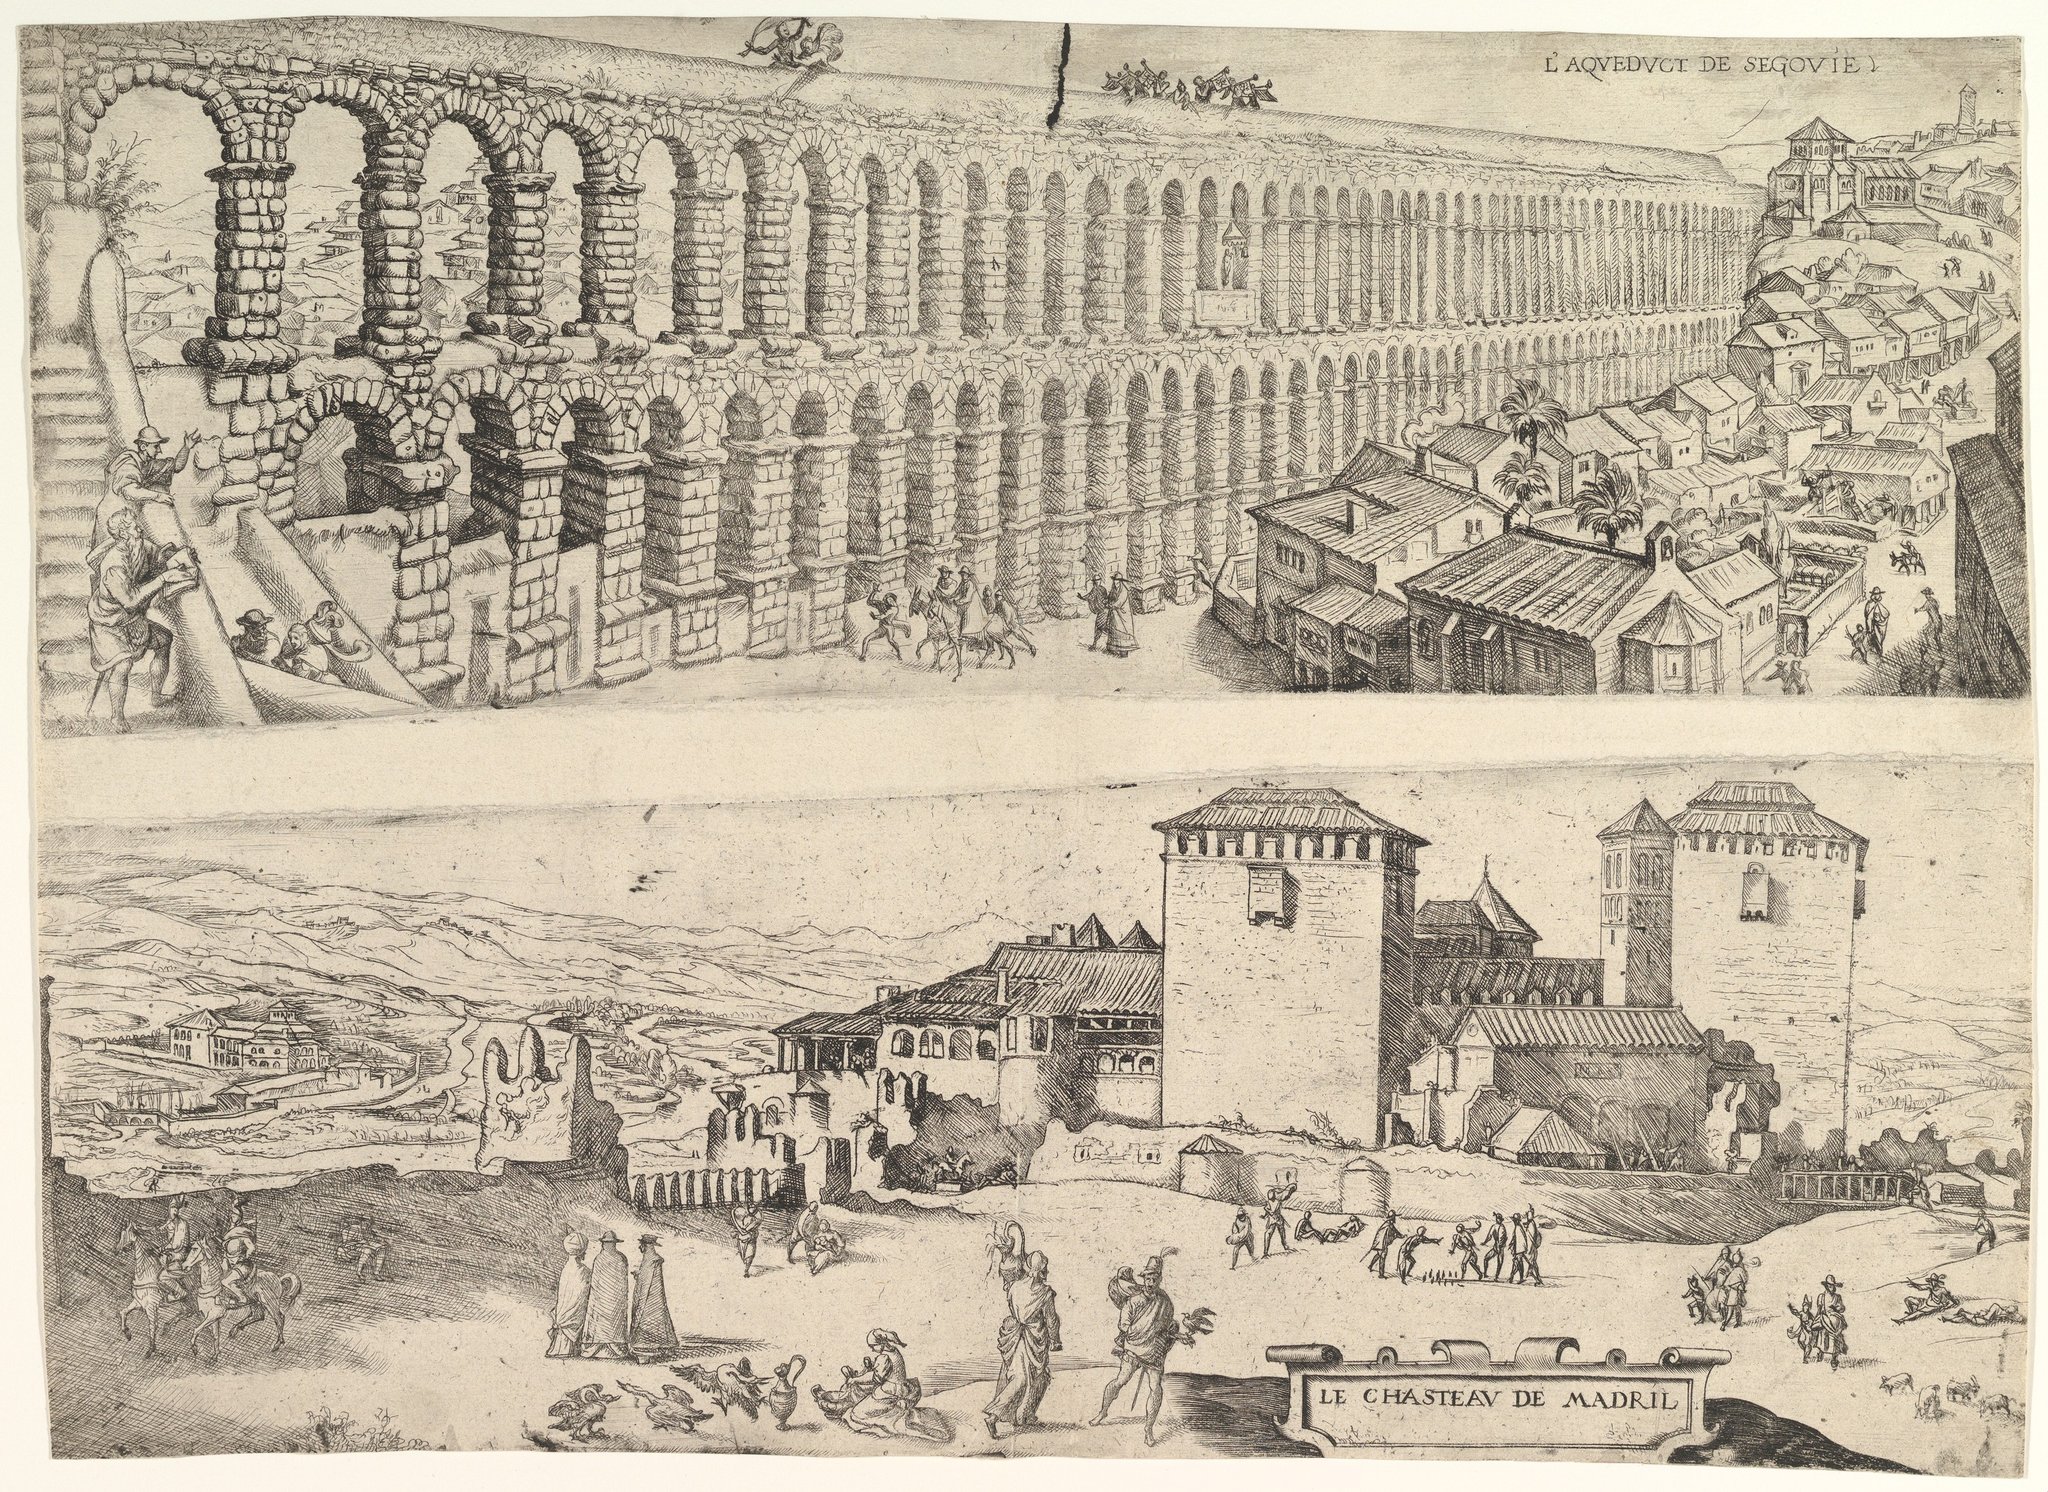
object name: print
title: The Aqueduct at Segovia and The Castle of Madrid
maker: jan cornelisz vermeyen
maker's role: artist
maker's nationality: netherlandish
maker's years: 1504-1559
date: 1500-1599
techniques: etching, printing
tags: architecture,castles,horses,aqueducts